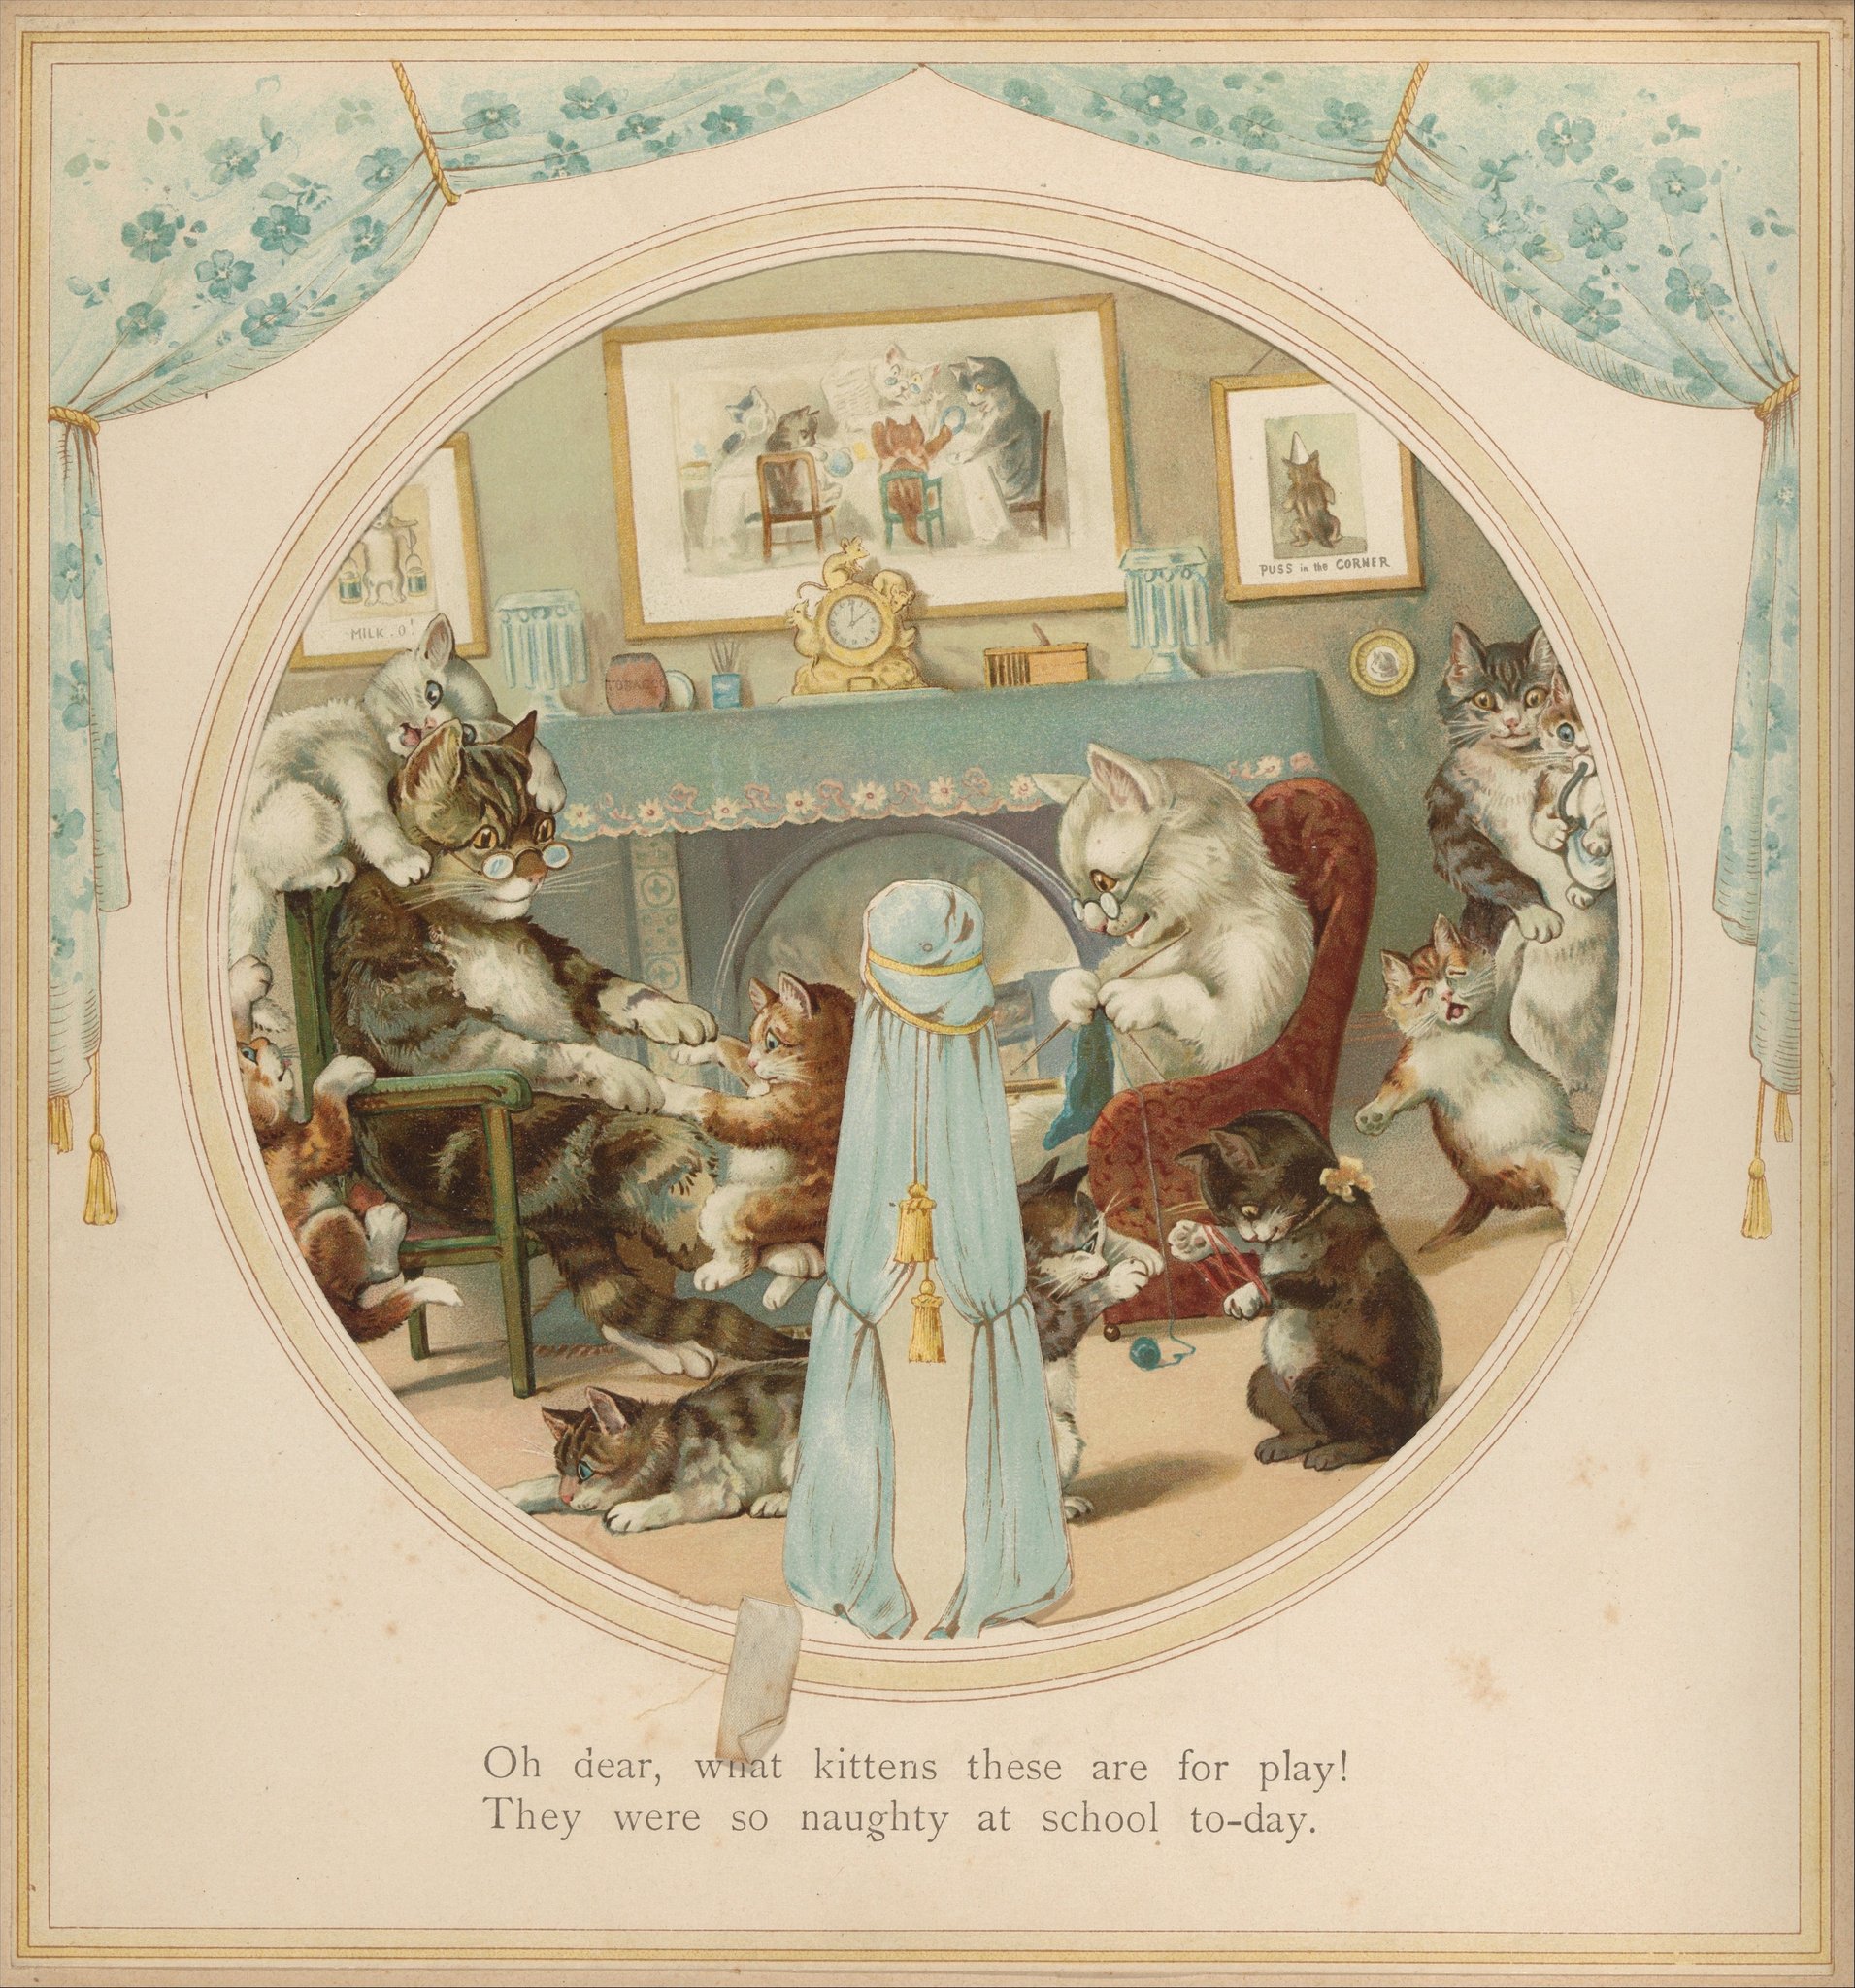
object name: book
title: Revolving Pictures, A Novel Colour Book with Dioramic Effects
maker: clifton bingham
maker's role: author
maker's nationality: british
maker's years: 1859-1913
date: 1891-1899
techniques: lithograph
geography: germany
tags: cats,clocks,chairs